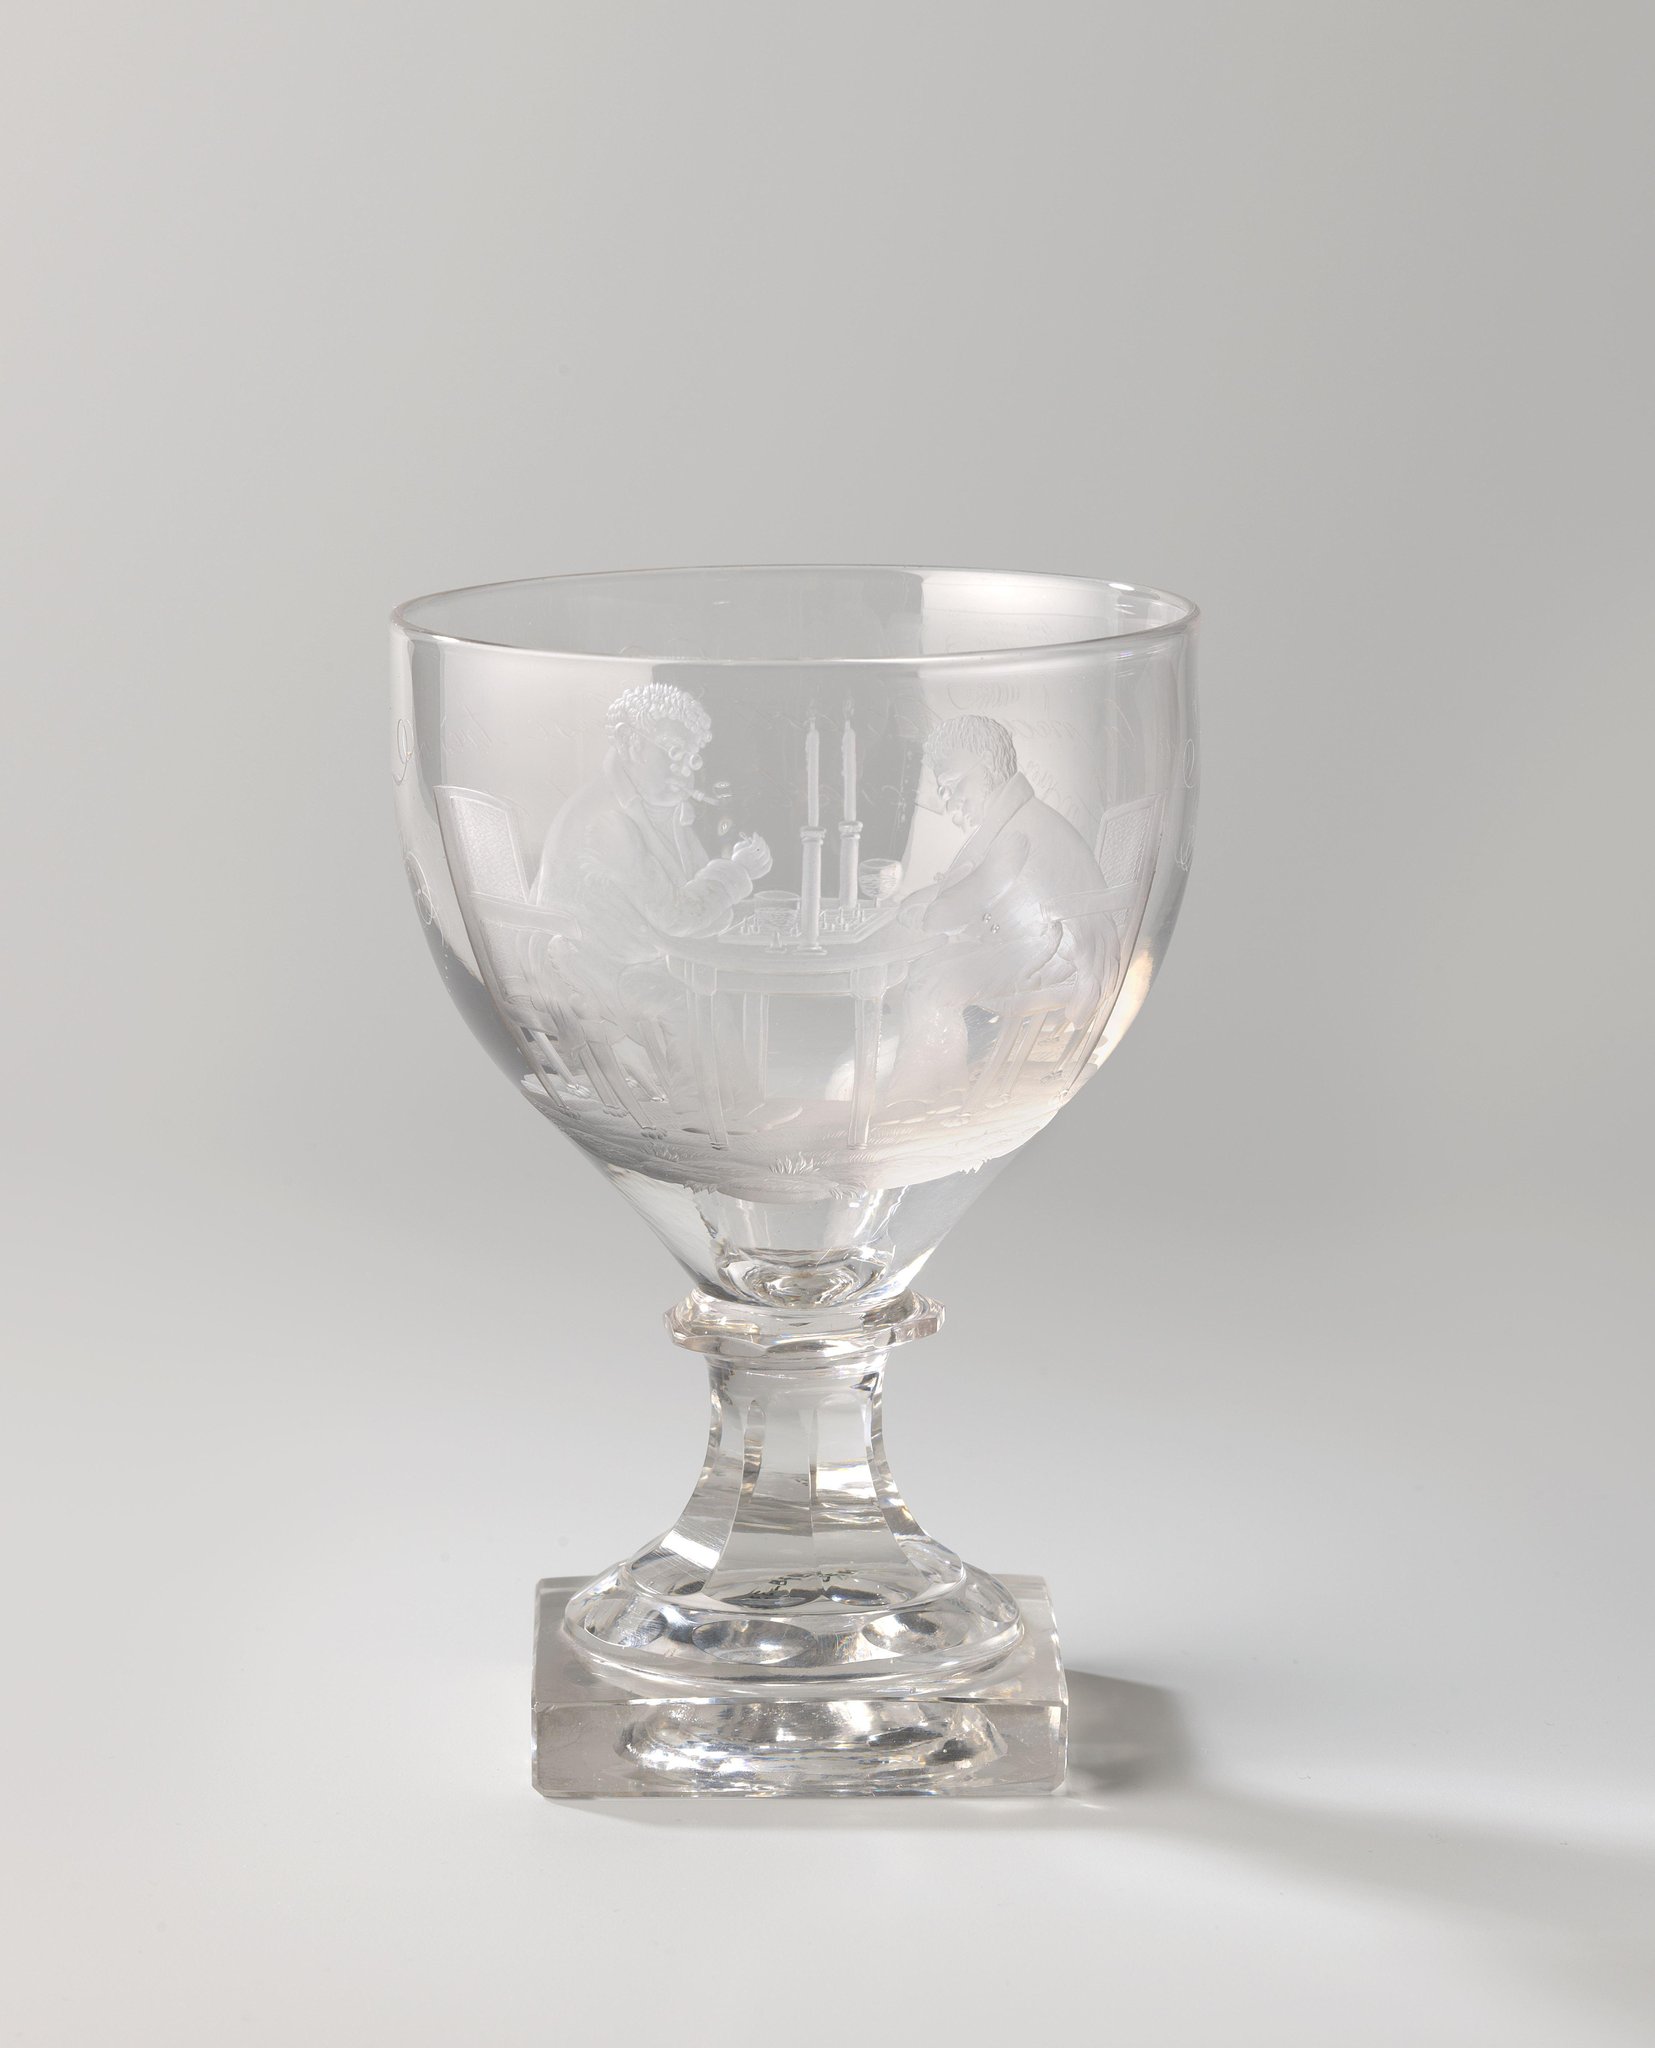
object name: goblet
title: Kelkglas op voet, met twee mannen aan een speeltafel en het opschrift: Savoir la marche, est Chose très unie Savoir le Jeu, c'est Fruit du genie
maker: Anonymous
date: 1815-1830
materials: glass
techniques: glassblowing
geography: northern netherlands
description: Two men at a games table. Wheel engraving, c. 1815 - 1830.